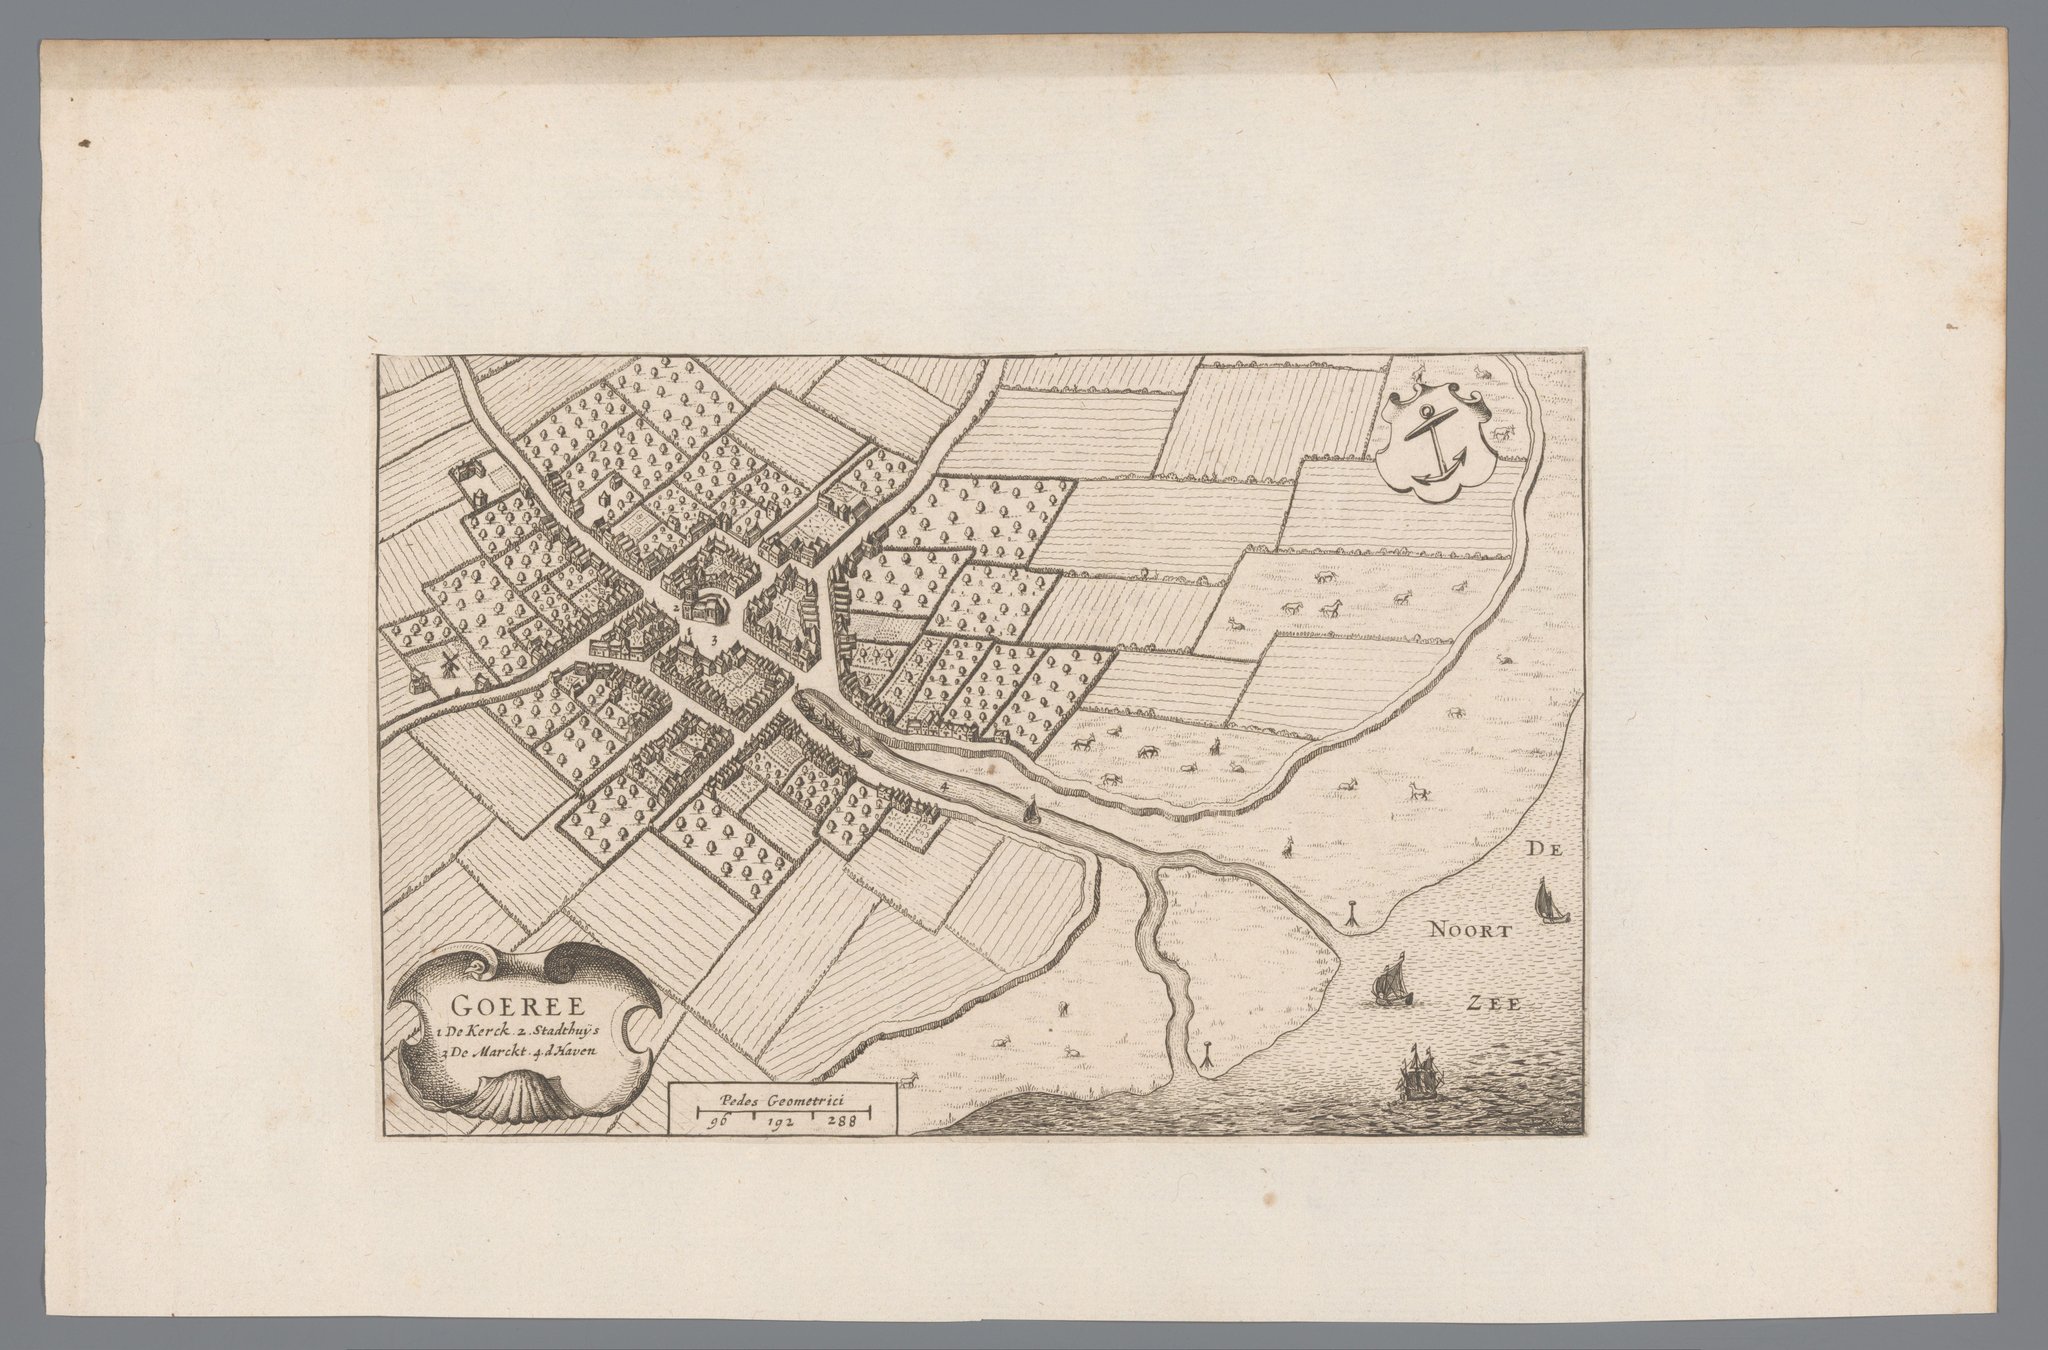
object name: book illustration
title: Goeree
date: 1632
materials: paper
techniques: etching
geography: amsterdam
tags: maps of cities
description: Linksonder een cartouche met de titel en een legenda 1-4. Rechts daarvan een schaalstok: 288 pedes geometrici. Rechtsboven een wapenschild met een anker (mogelijk een variant op het wapen van de stad).